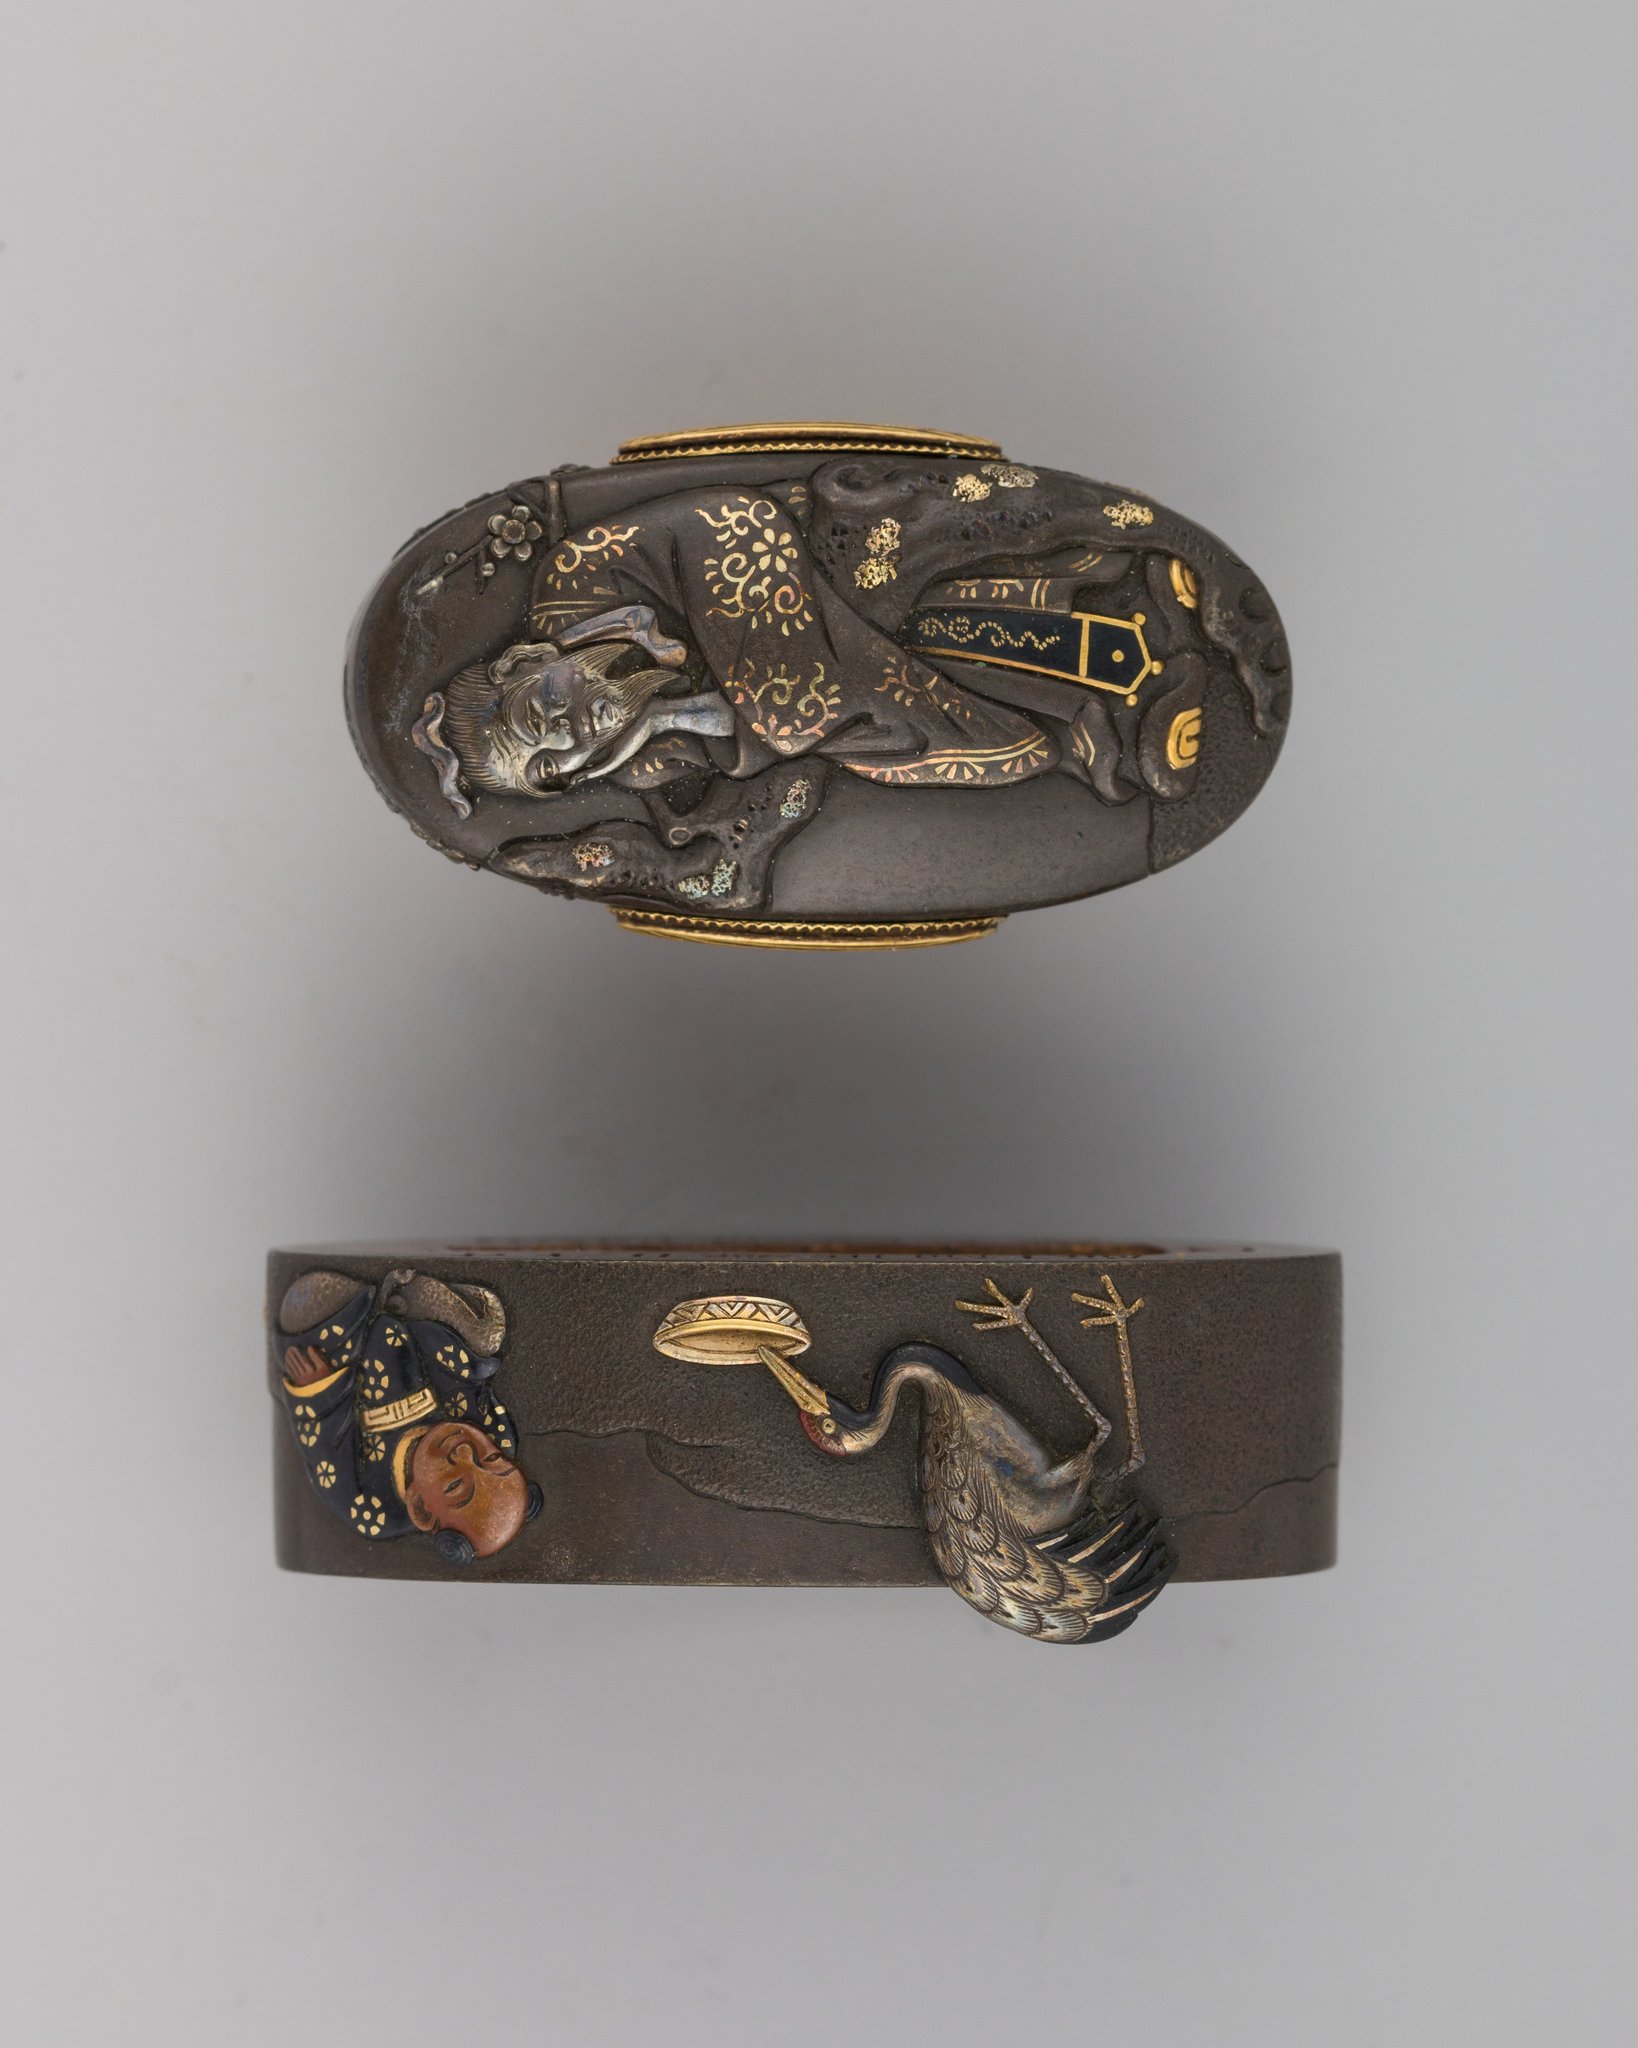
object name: sword hilt collar and pommel fuchigashira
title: Sword-Hilt Collar and Pommel (Fuchigashira)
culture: japanese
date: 1701-1800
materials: copper, gold alloy, silver alloy, gold, silver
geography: japan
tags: cranes,men